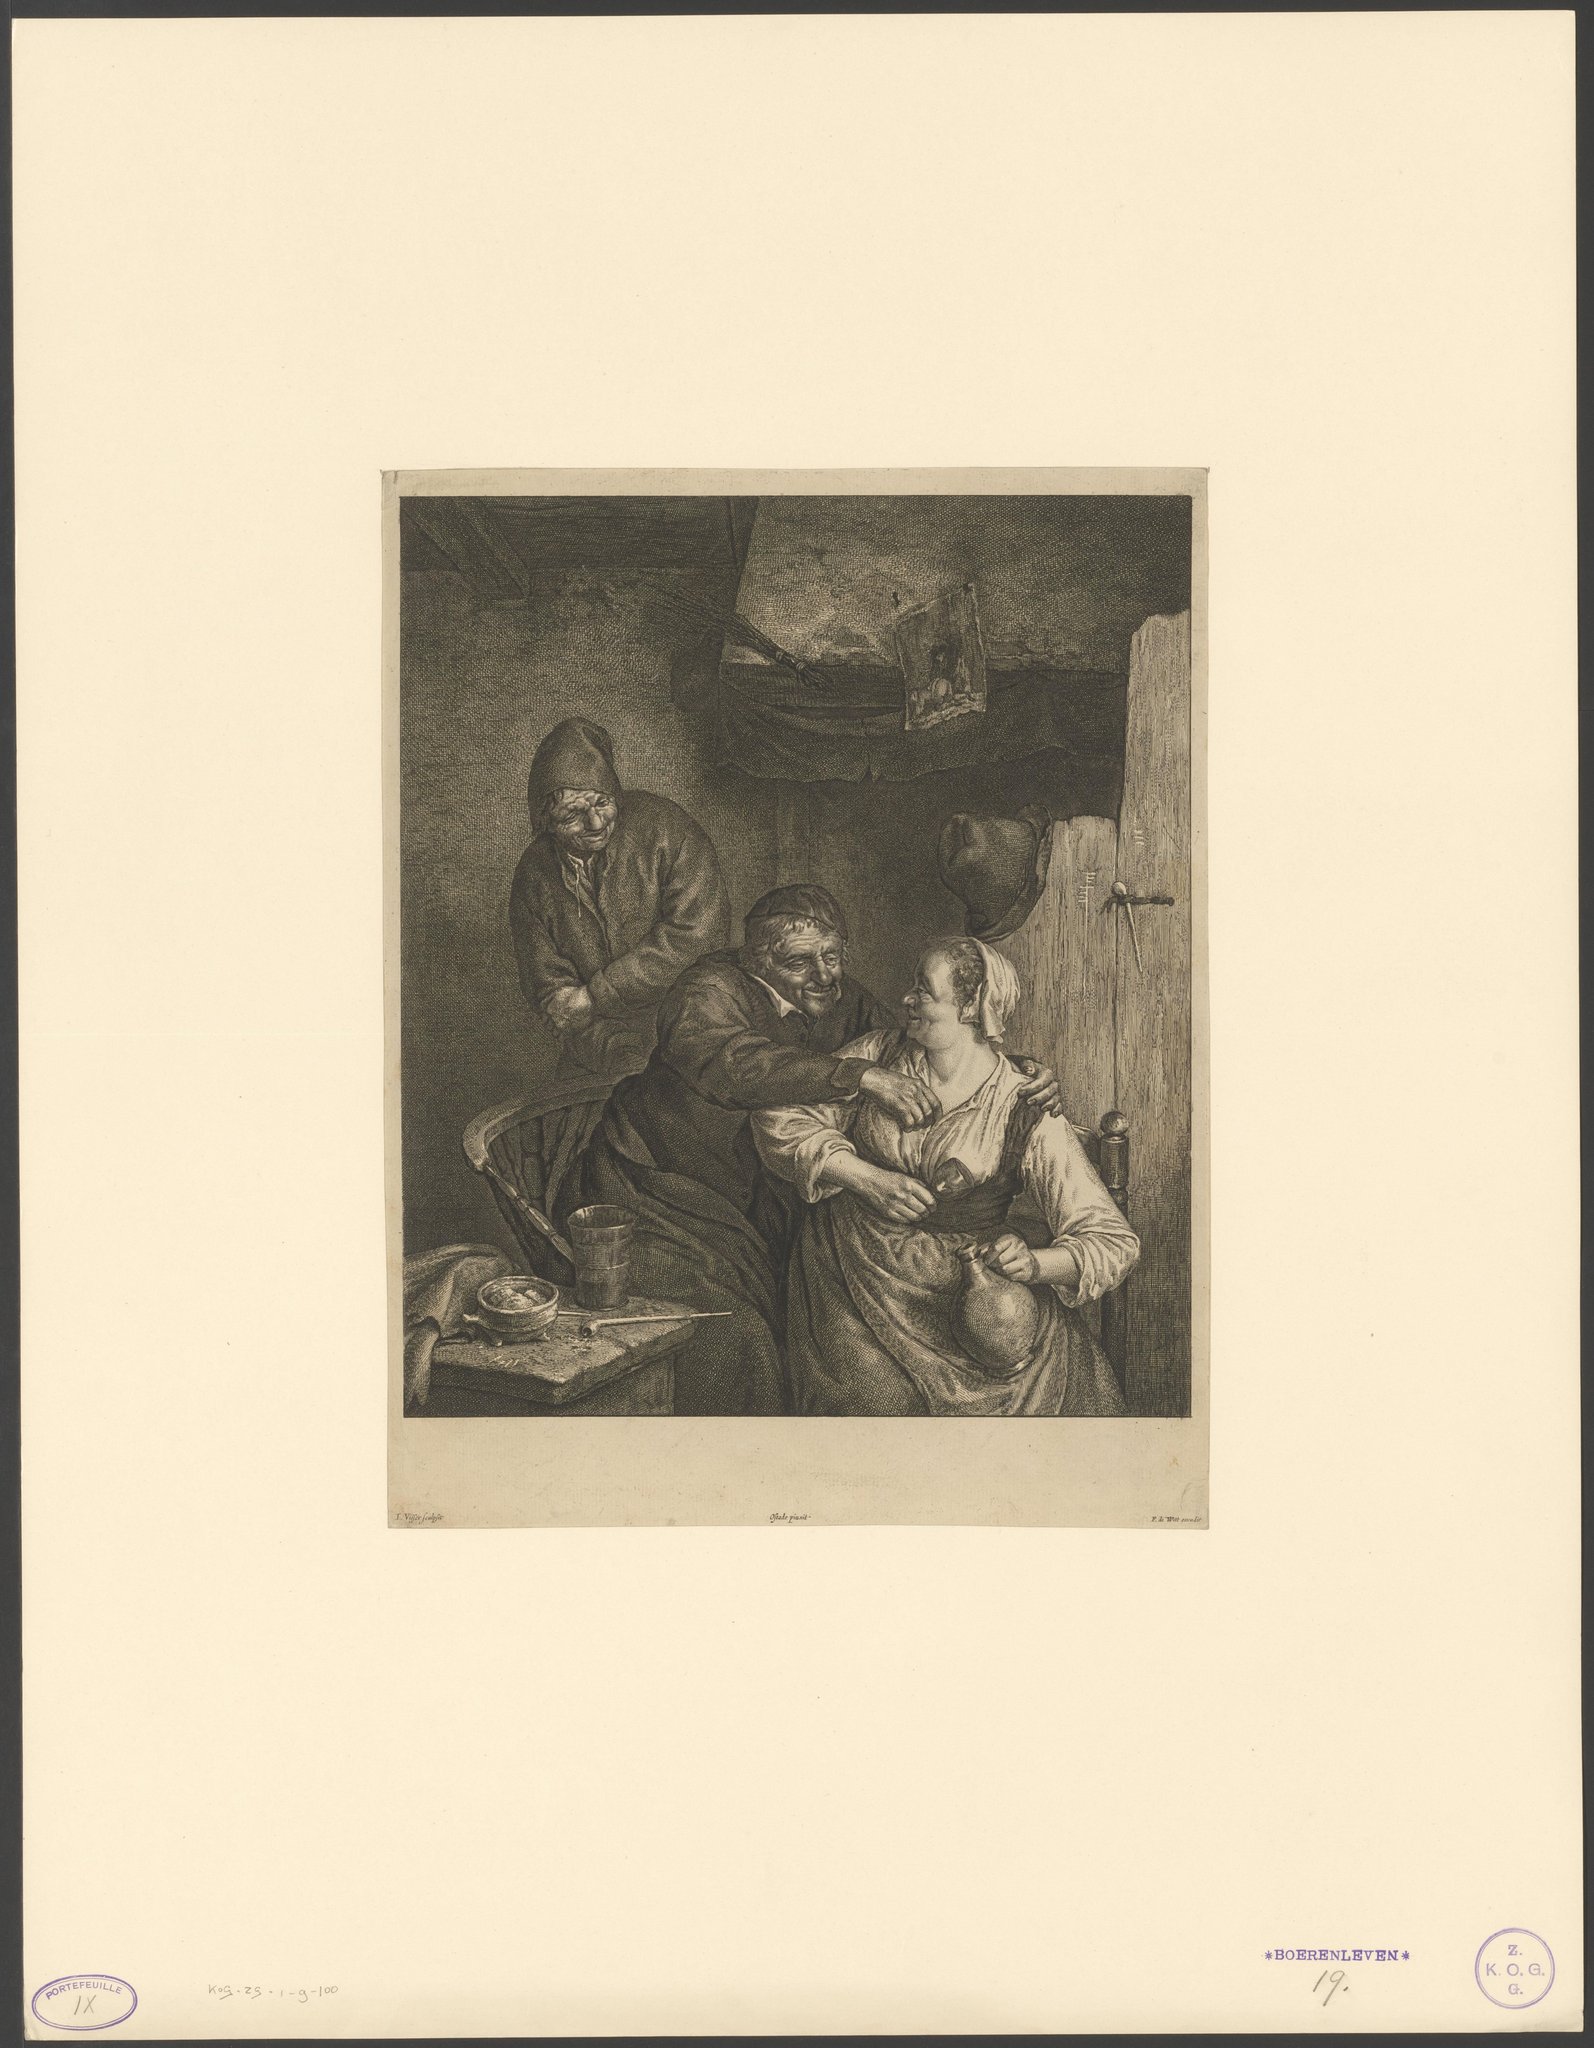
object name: print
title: Dwepende boer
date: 1643-1712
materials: paper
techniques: engraving, etching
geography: amsterdam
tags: drunkard, farmers, one-sided courting; pursuit; difficult choice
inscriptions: stamp, collector's mark: Lugt 1641, stamp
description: Dronken boer in probeert zijn hand in de blouse van een vrouw te steken. Een andere boer kijkt glimlachend toe. Op tafel liggen pijpen en tabak. Boven het stel hangt een schunnige prent. Onderwerpsrubrieken binnen de Atlas Zeden en Gewoonten: Handel, nijverheid en verkeer, Boerenleven.